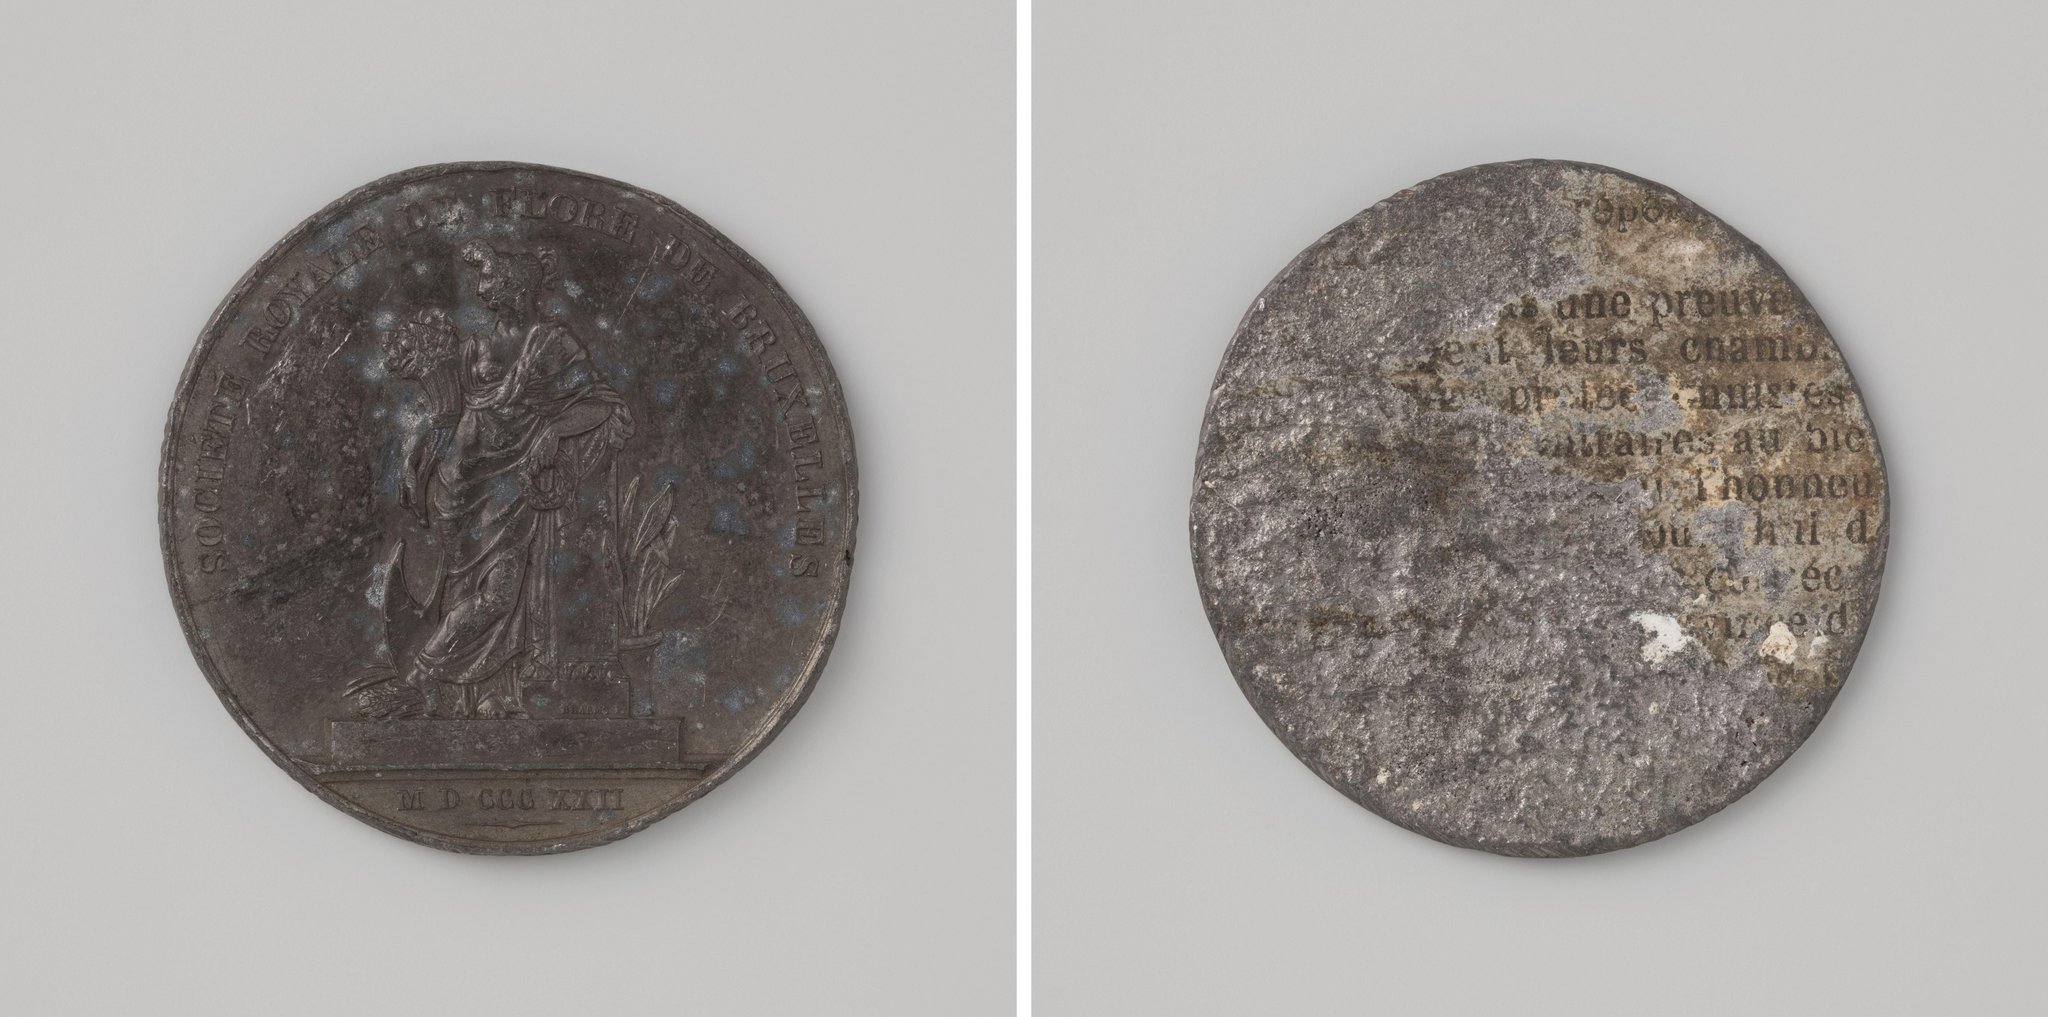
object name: history medal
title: Prijspenning van de Koninglijke Vereeniging Flora te Brussel 1822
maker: joseph pierre braemt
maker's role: print maker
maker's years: 1796-1864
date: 1822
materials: tin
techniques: pressing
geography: brussels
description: Afslag in tin van het voorzijdestempel, met Flora staand tegen een zuil, met omschrift en afsnedetekst.